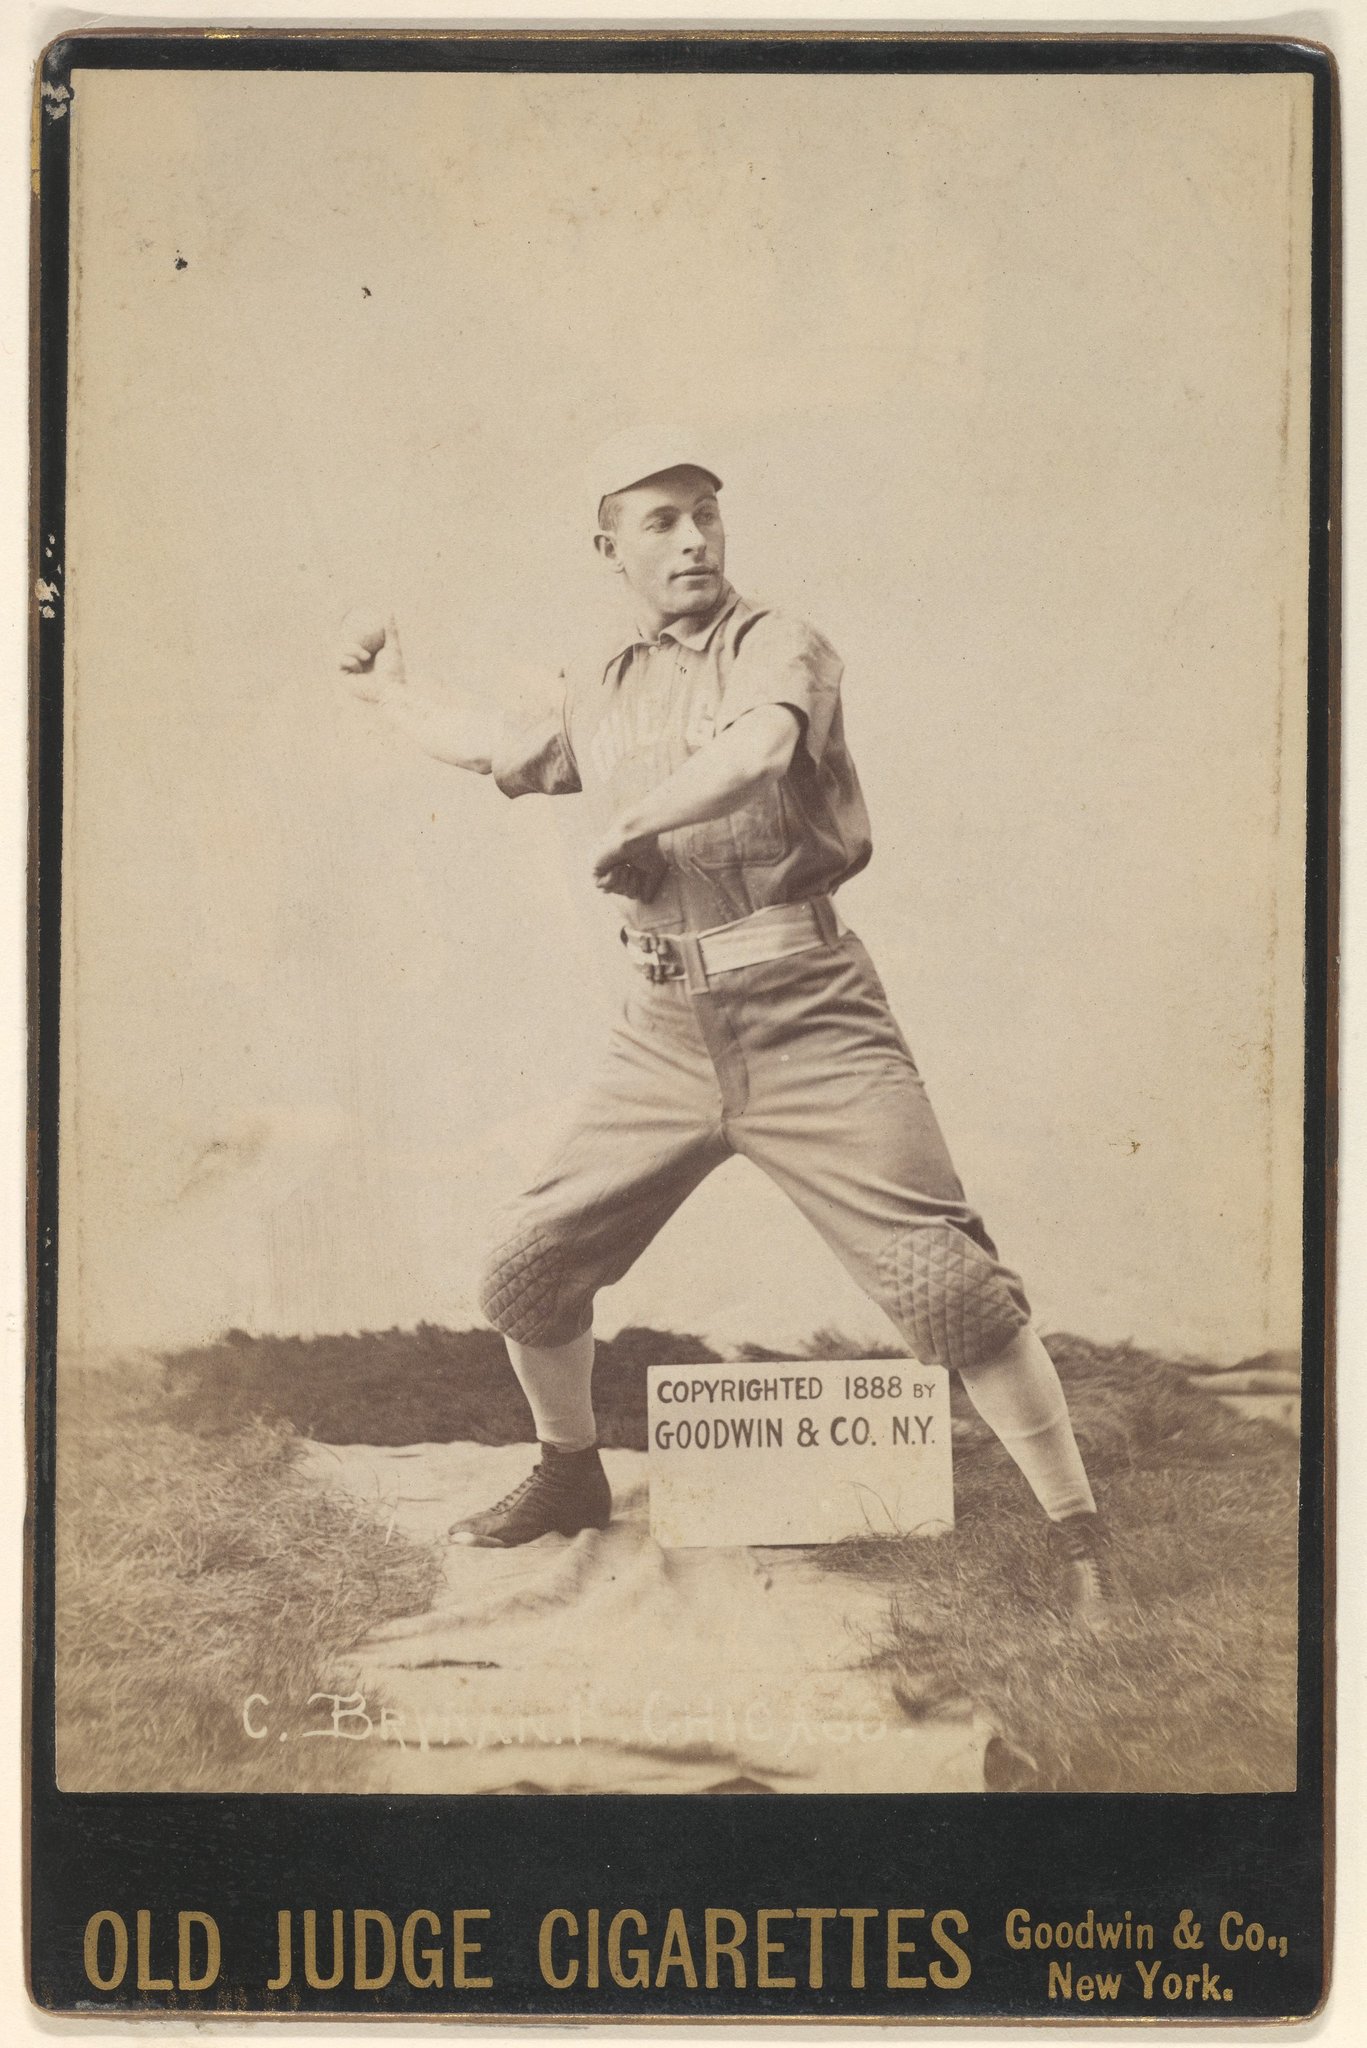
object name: baseball card, photograph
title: C. Crynan, Pitcher, Chicago, from the series Old Judge Cigarettes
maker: goodwin & company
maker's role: publisher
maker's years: 1850-1950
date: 1888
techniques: albumen silver print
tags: men,portraits,baseball,athletes